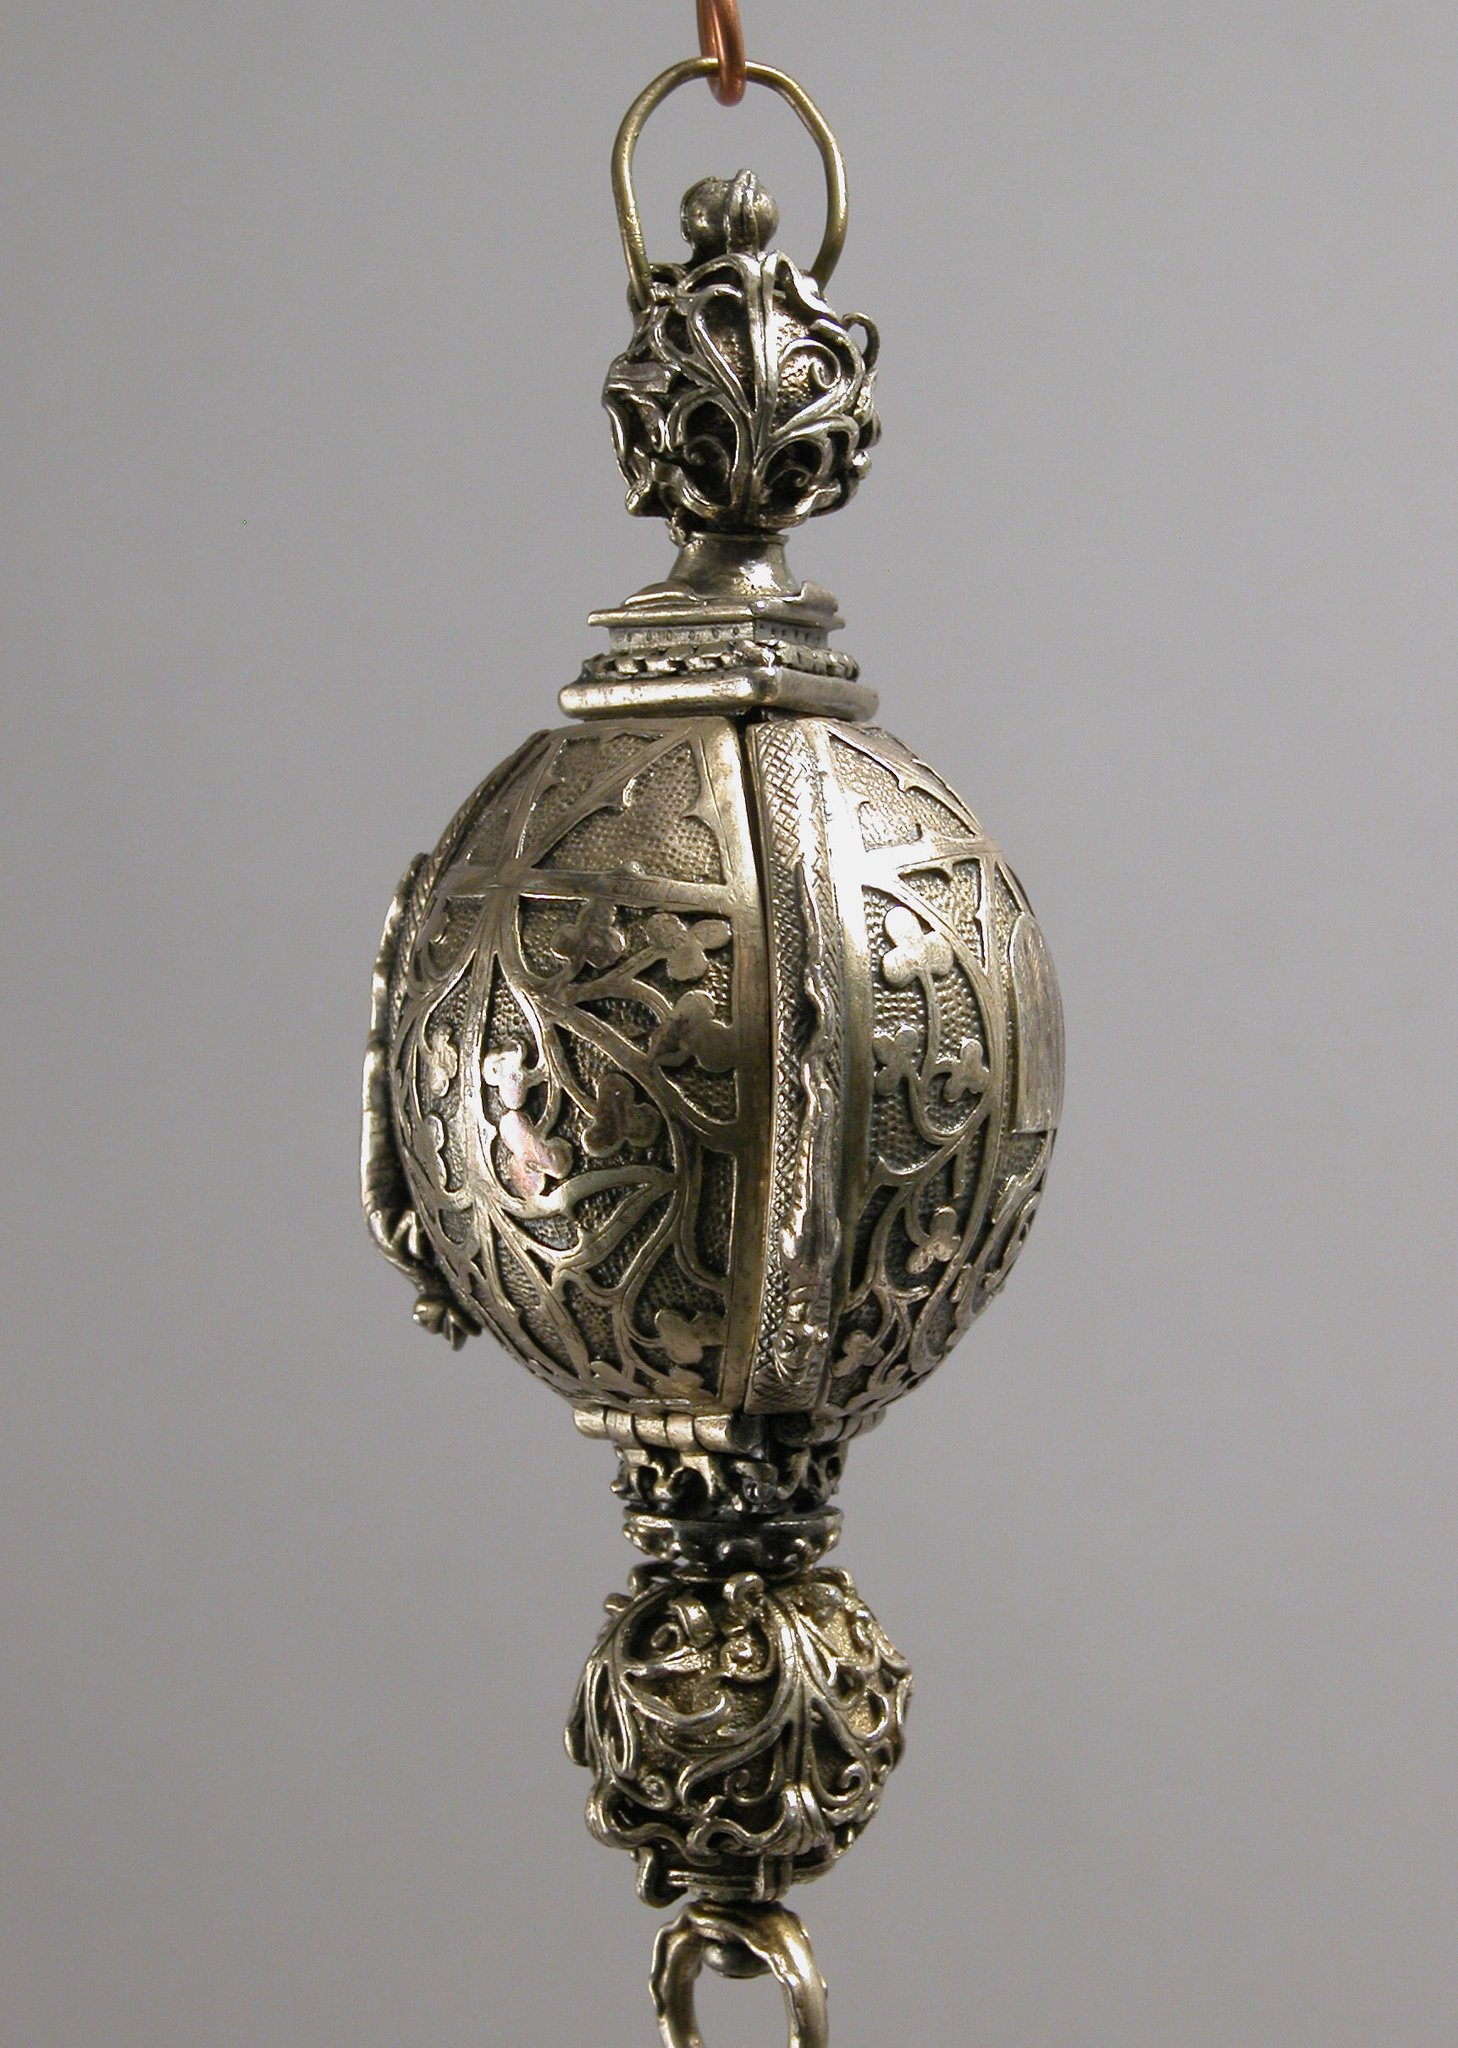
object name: pomander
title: Pomander Bead from a Rosary or Devotional Pendant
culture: french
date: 1801-1900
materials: silver gilt, thread, textile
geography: france